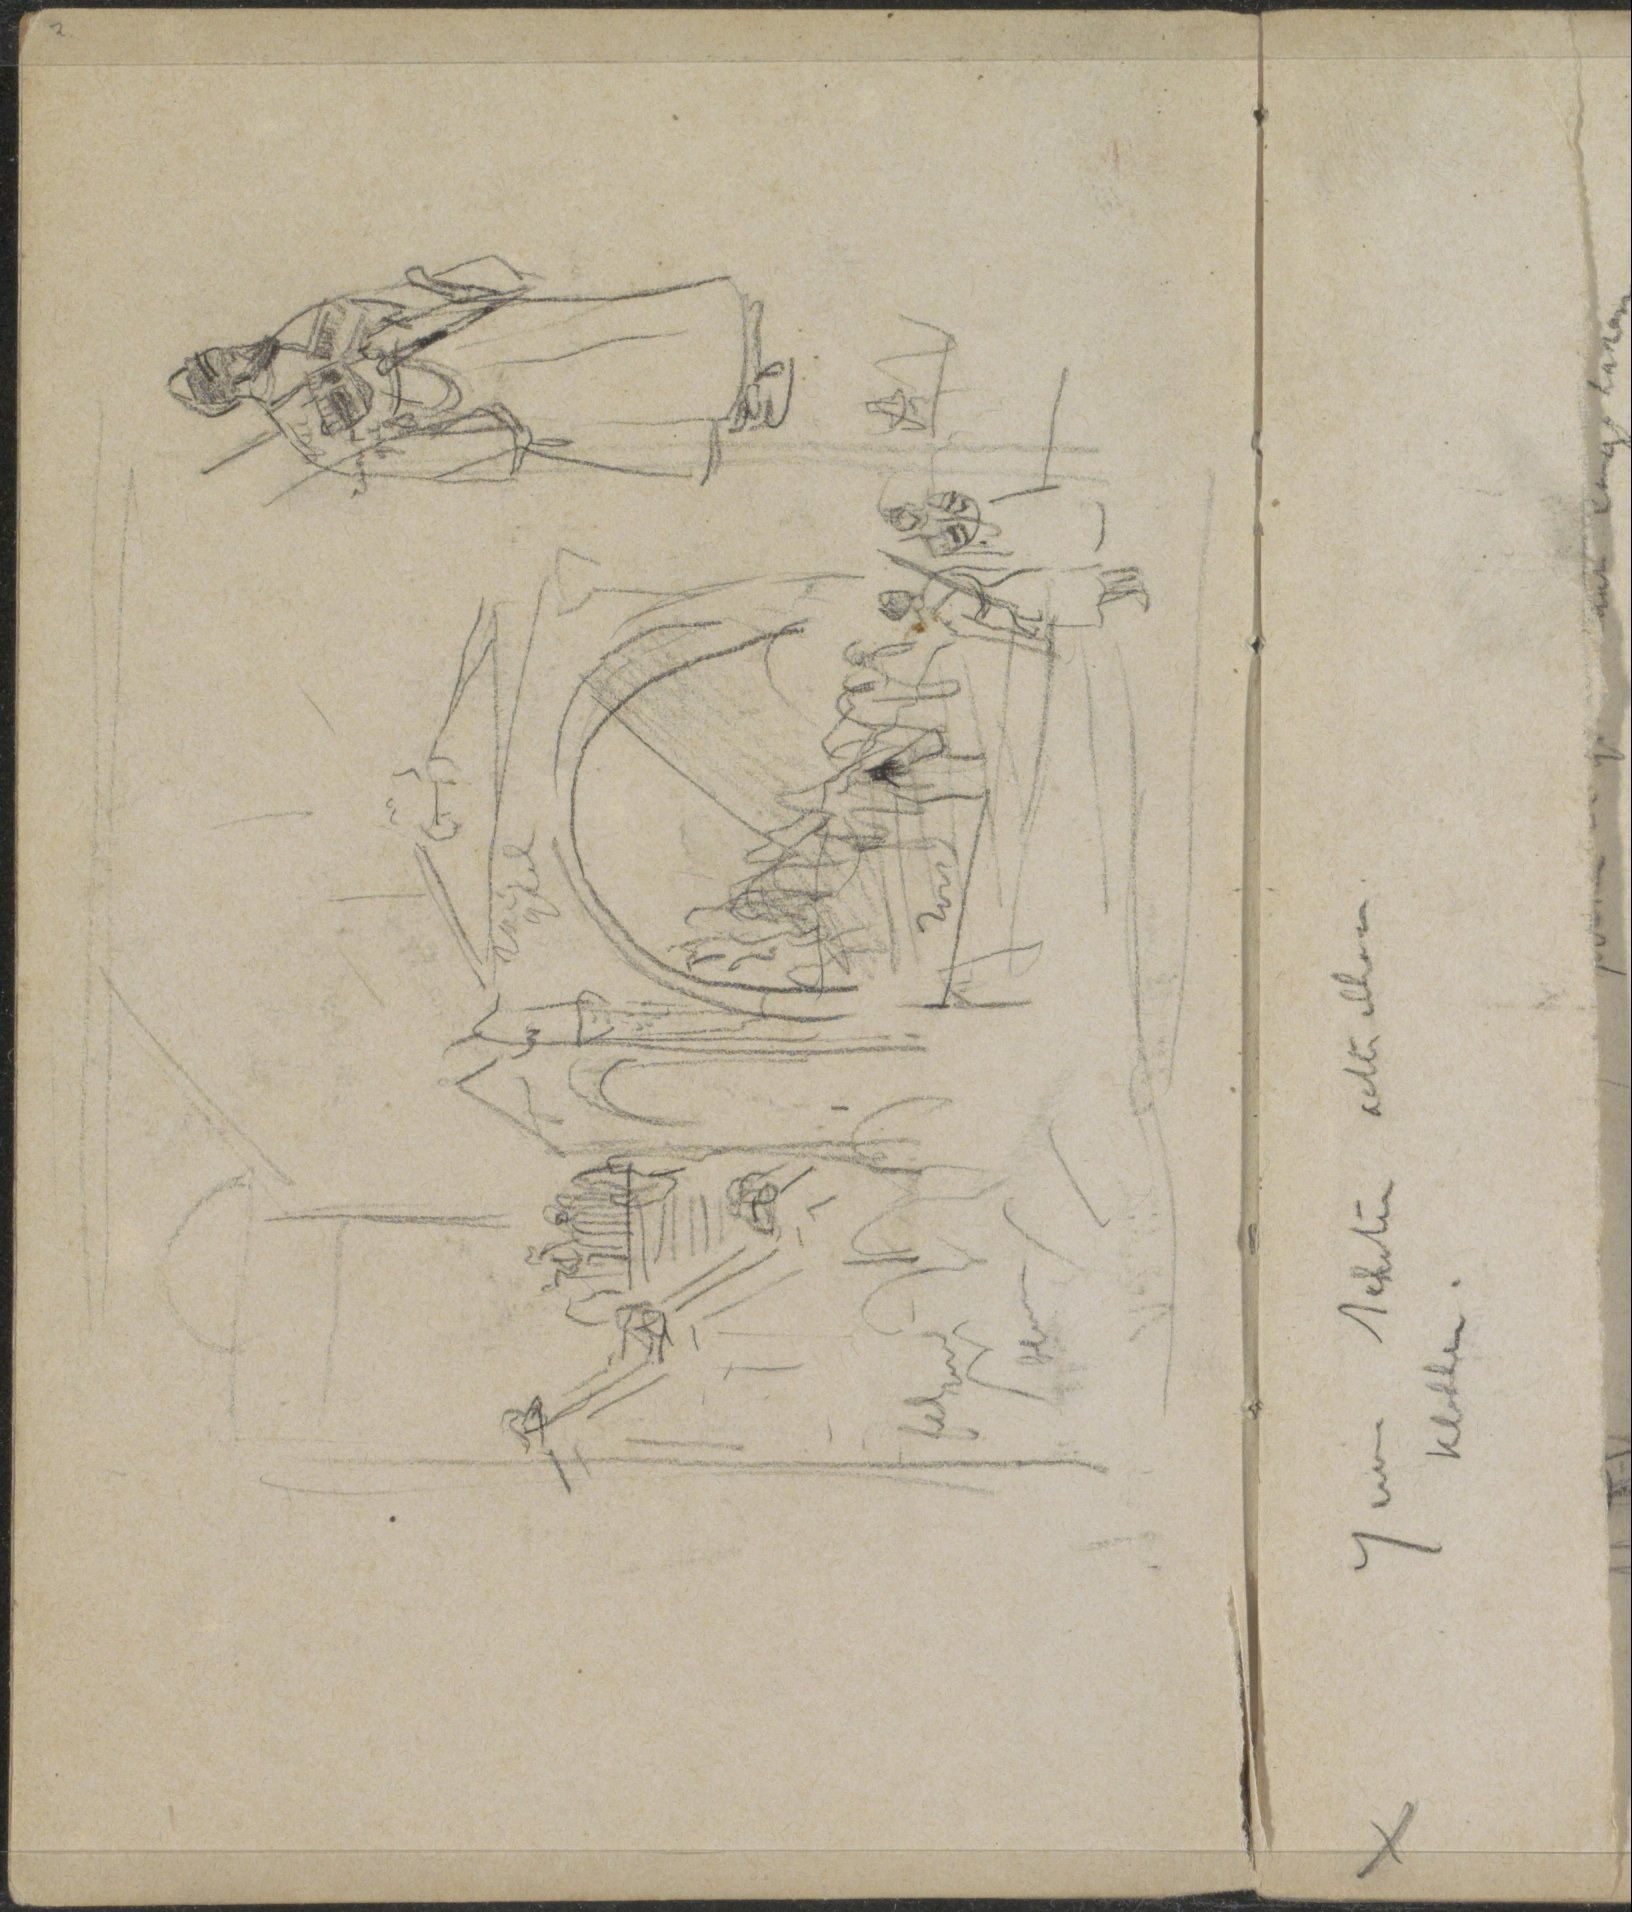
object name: sketchbook leaf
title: Processie bij de trap en Rode Veranda van het Granovitaya Palata te Moskou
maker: marius bauer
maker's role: draughtsman, print maker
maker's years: 1867-1932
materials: chalk, paper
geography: moscow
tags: flight of steps, arch, archivolt ~ architecture, palace, ornamental parts of clothing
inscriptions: annotation: ‘7 uur [...]/ klokken’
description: De trap en veranda maakten deel uit van de route van de processie voor de kroning van tsaar Nicolaas II. Pagina 2 uit een schetsboek met 54 bladen.